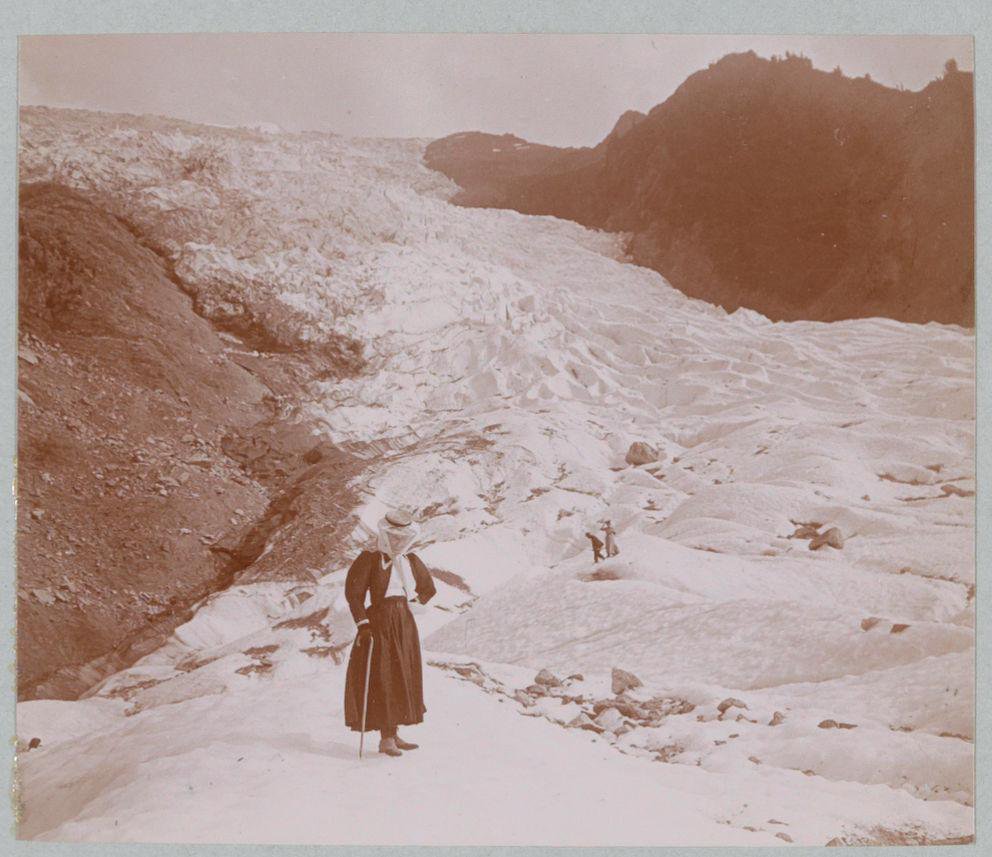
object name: photograph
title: Wandelaars op een gletsjer in de Alpen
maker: Anonymous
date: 1905-1910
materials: paper, photographic support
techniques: gelatin silver print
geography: alps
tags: walking, hiking (recreation), glacier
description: Onderdeel van Fotoalbum van een Franse amateurfotograaf met bezienswaardigheden in Frankrijk, Zwitserland en Italië.